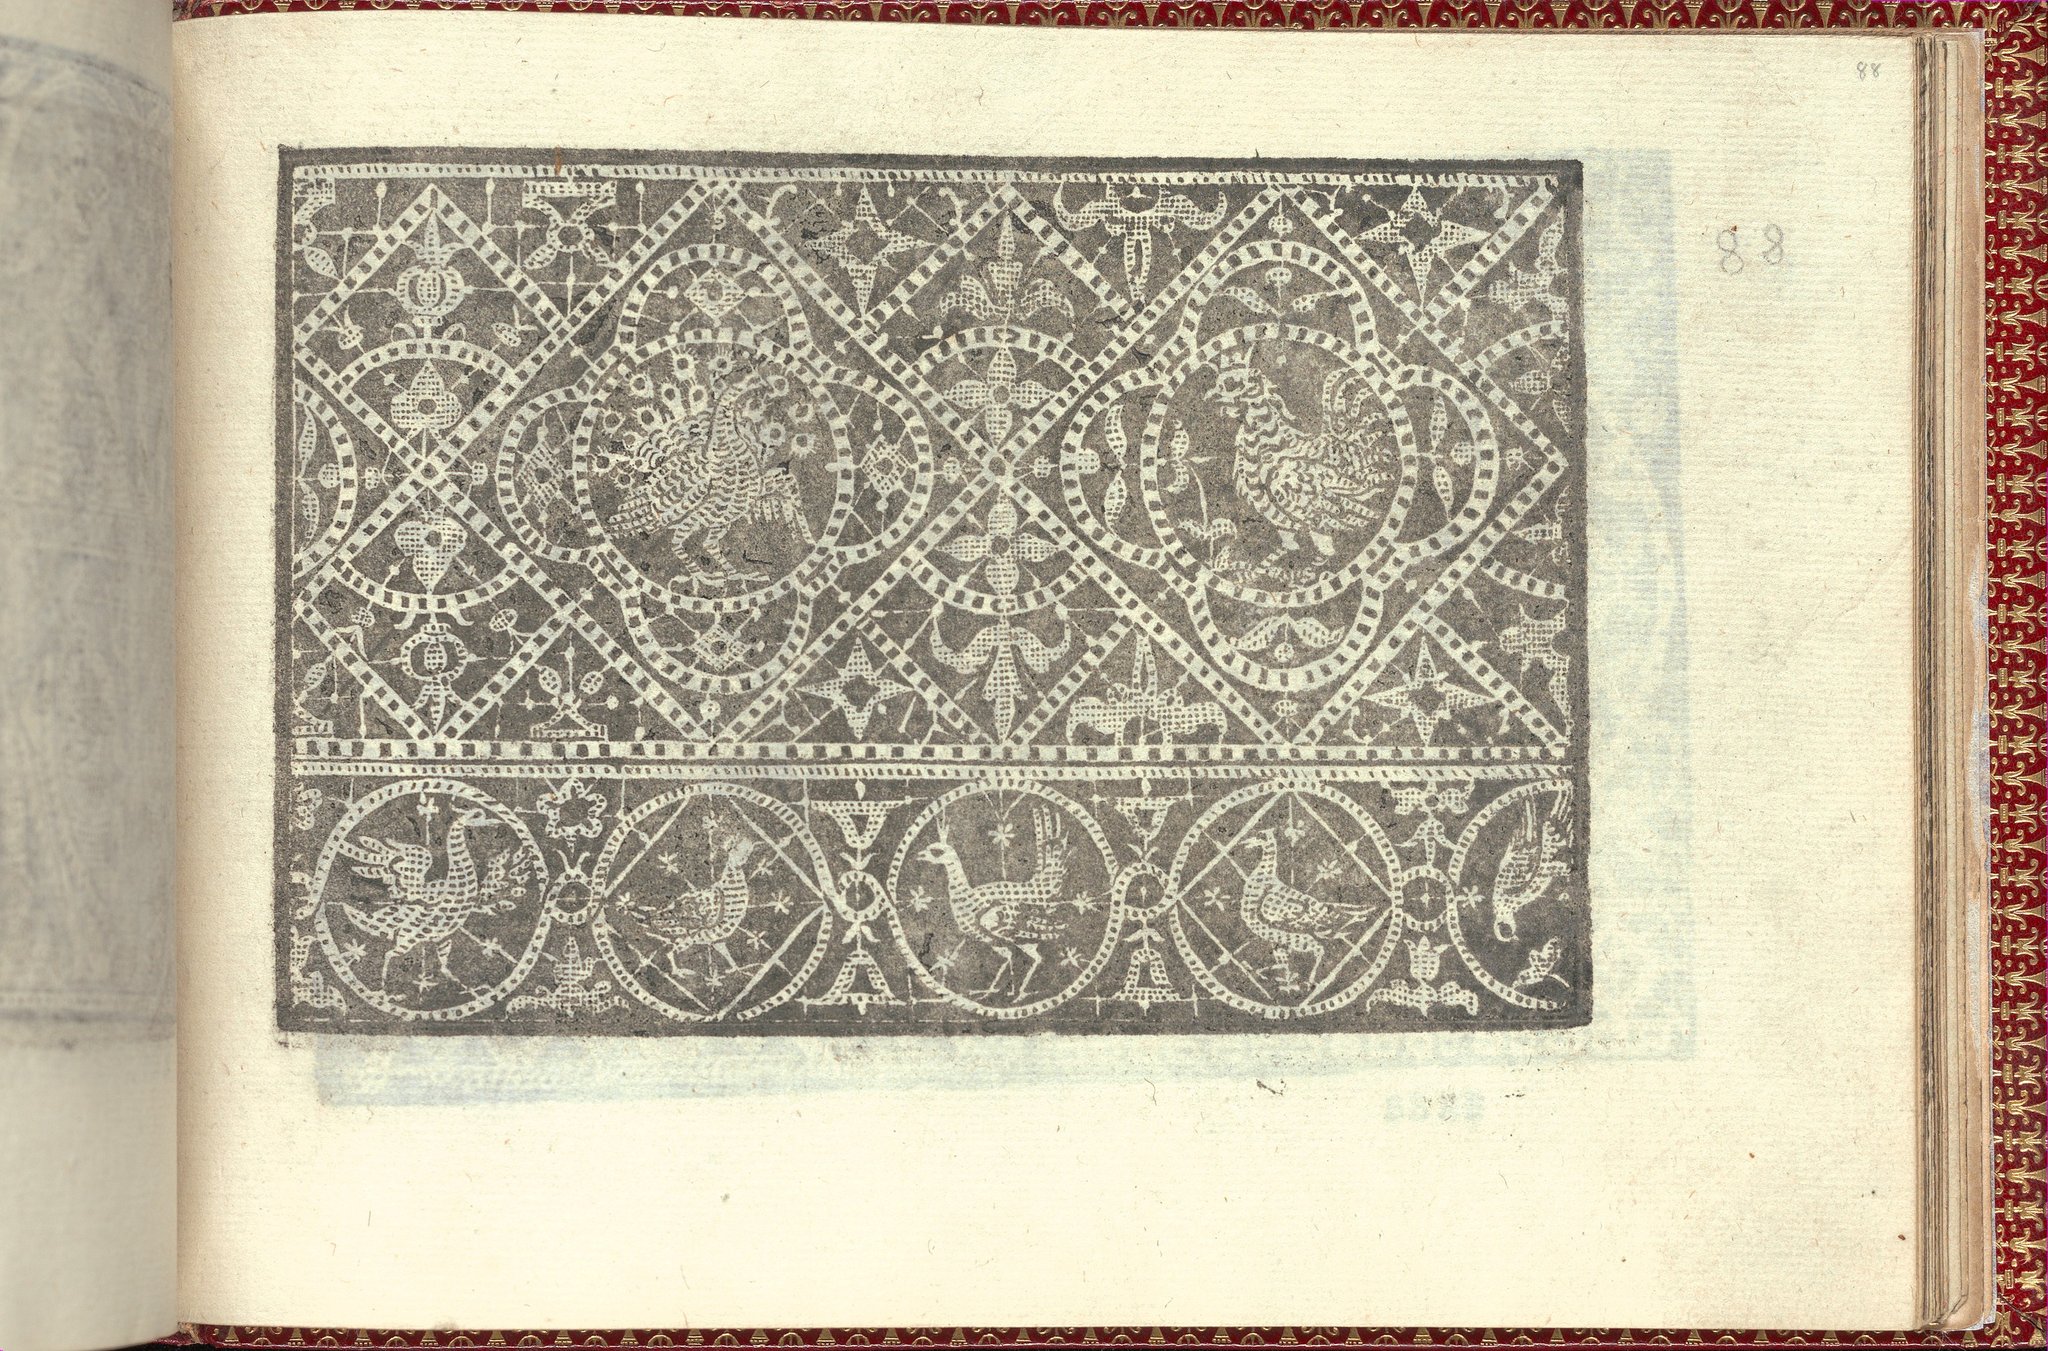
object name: book print ornament architecture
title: Corona delle Nobili et Virtuose Donne: Libro I-IV, page 88 (recto)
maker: cesare vecellio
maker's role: publisher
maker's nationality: italian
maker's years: 1521-1601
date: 1601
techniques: woodcut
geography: italy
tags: birds,ornament